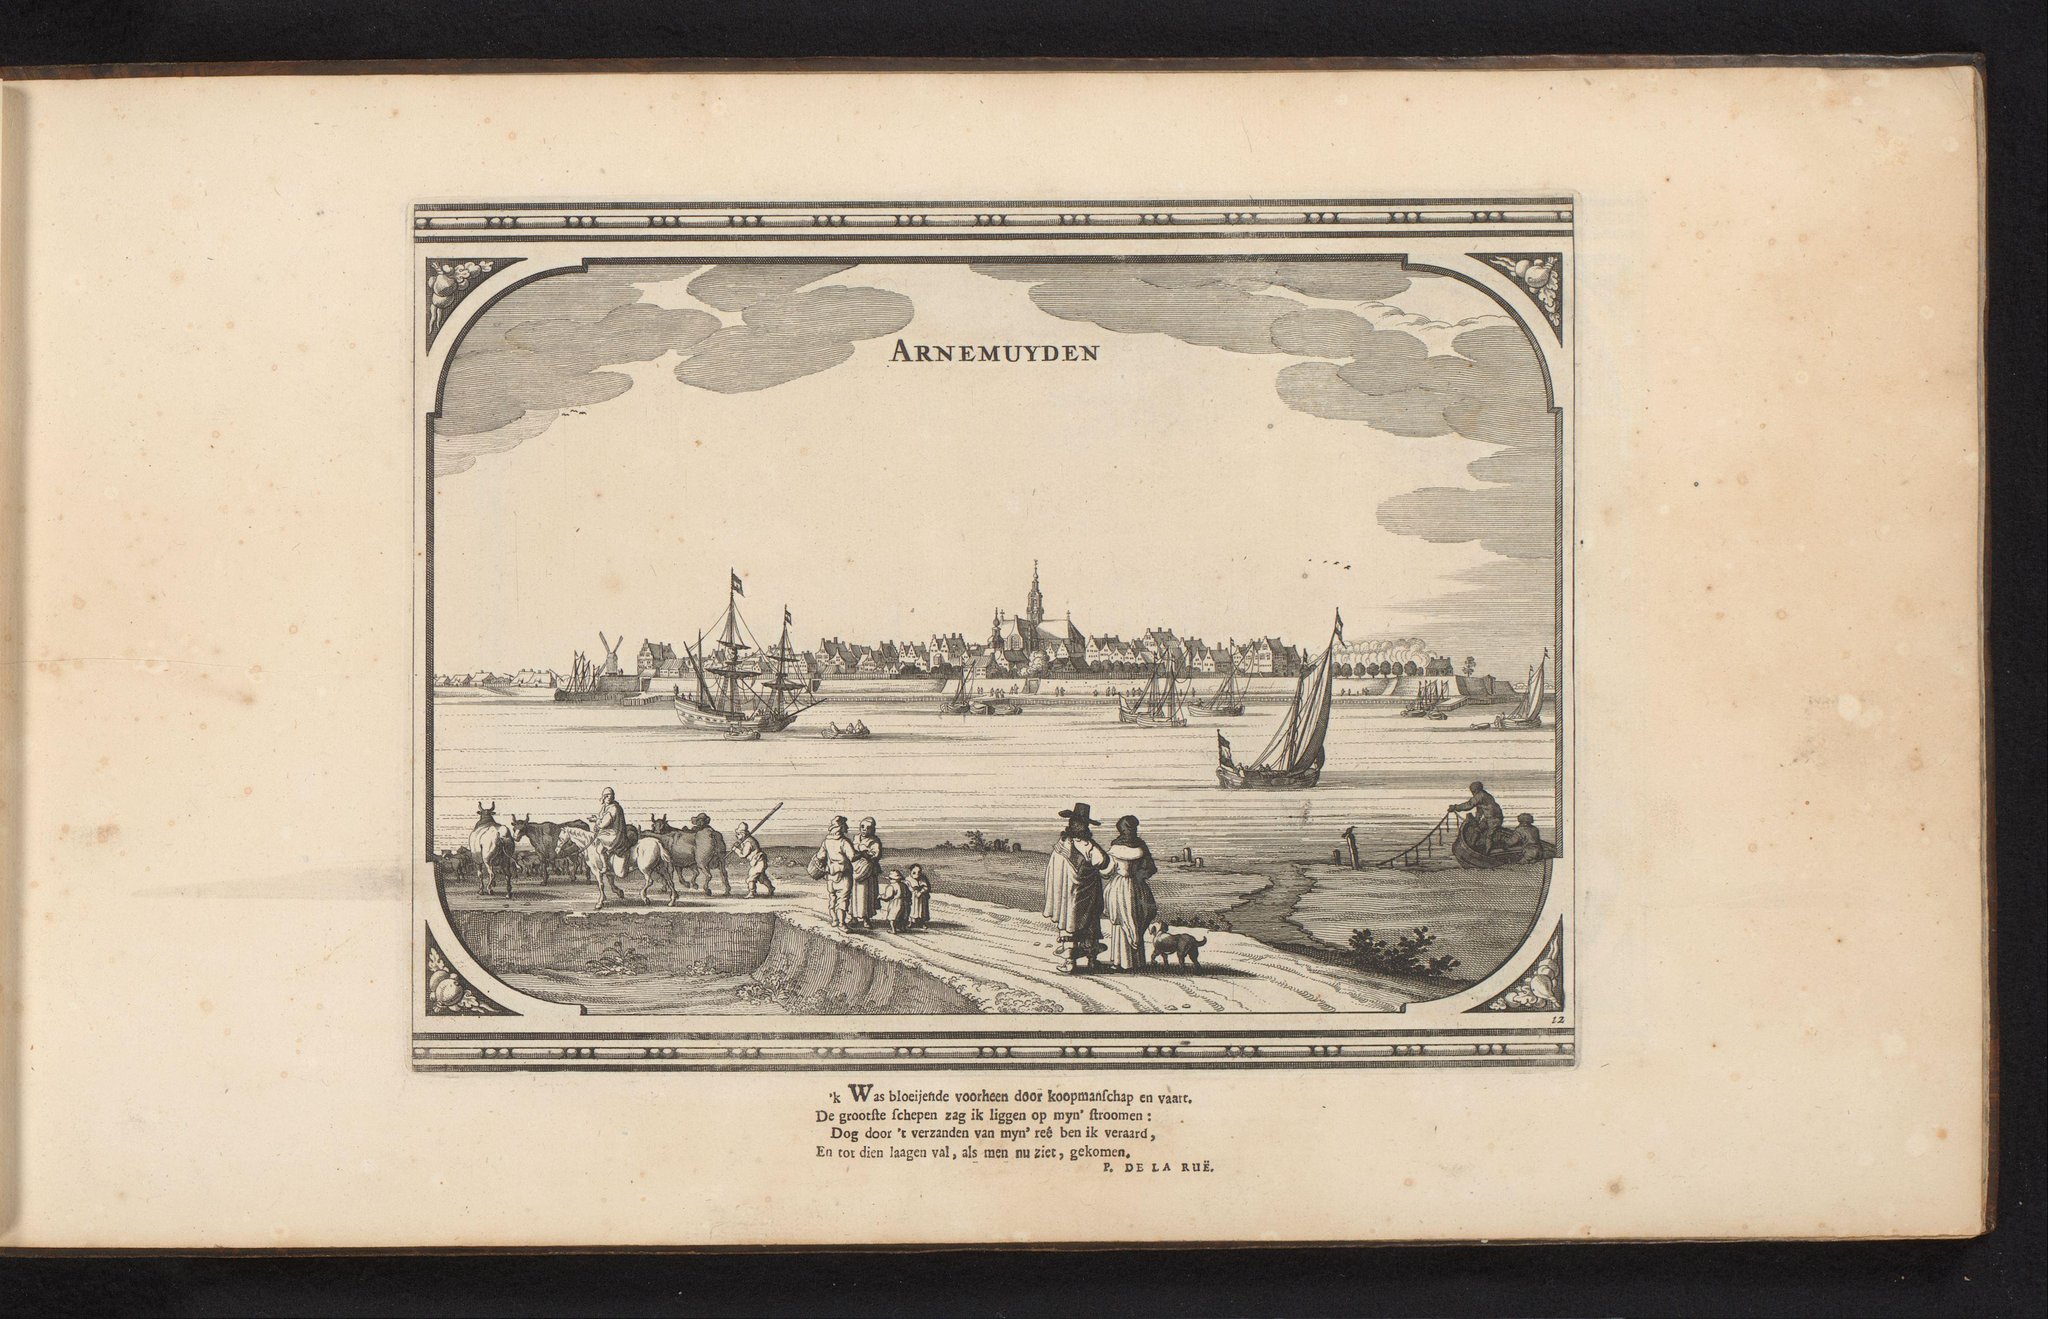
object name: print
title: Speculum Zelandiae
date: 1731-1800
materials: paper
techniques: etching, letterpress printing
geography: middelburg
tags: city-view, and landscape with man-made constructions, river, walking the dog, walking arm in arm, arm in arm (lovers)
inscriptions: collector's mark: Lugt 195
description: Gezicht op de stad Arnemuiden, vanaf het Veerse meer. Op het water varen verschillende schepen. Op de voorgrond een weg met boeren en een welgesteld paar met hond. Daaronder vier versregels in het Nederlands. De prent maakt deel uit van een album.